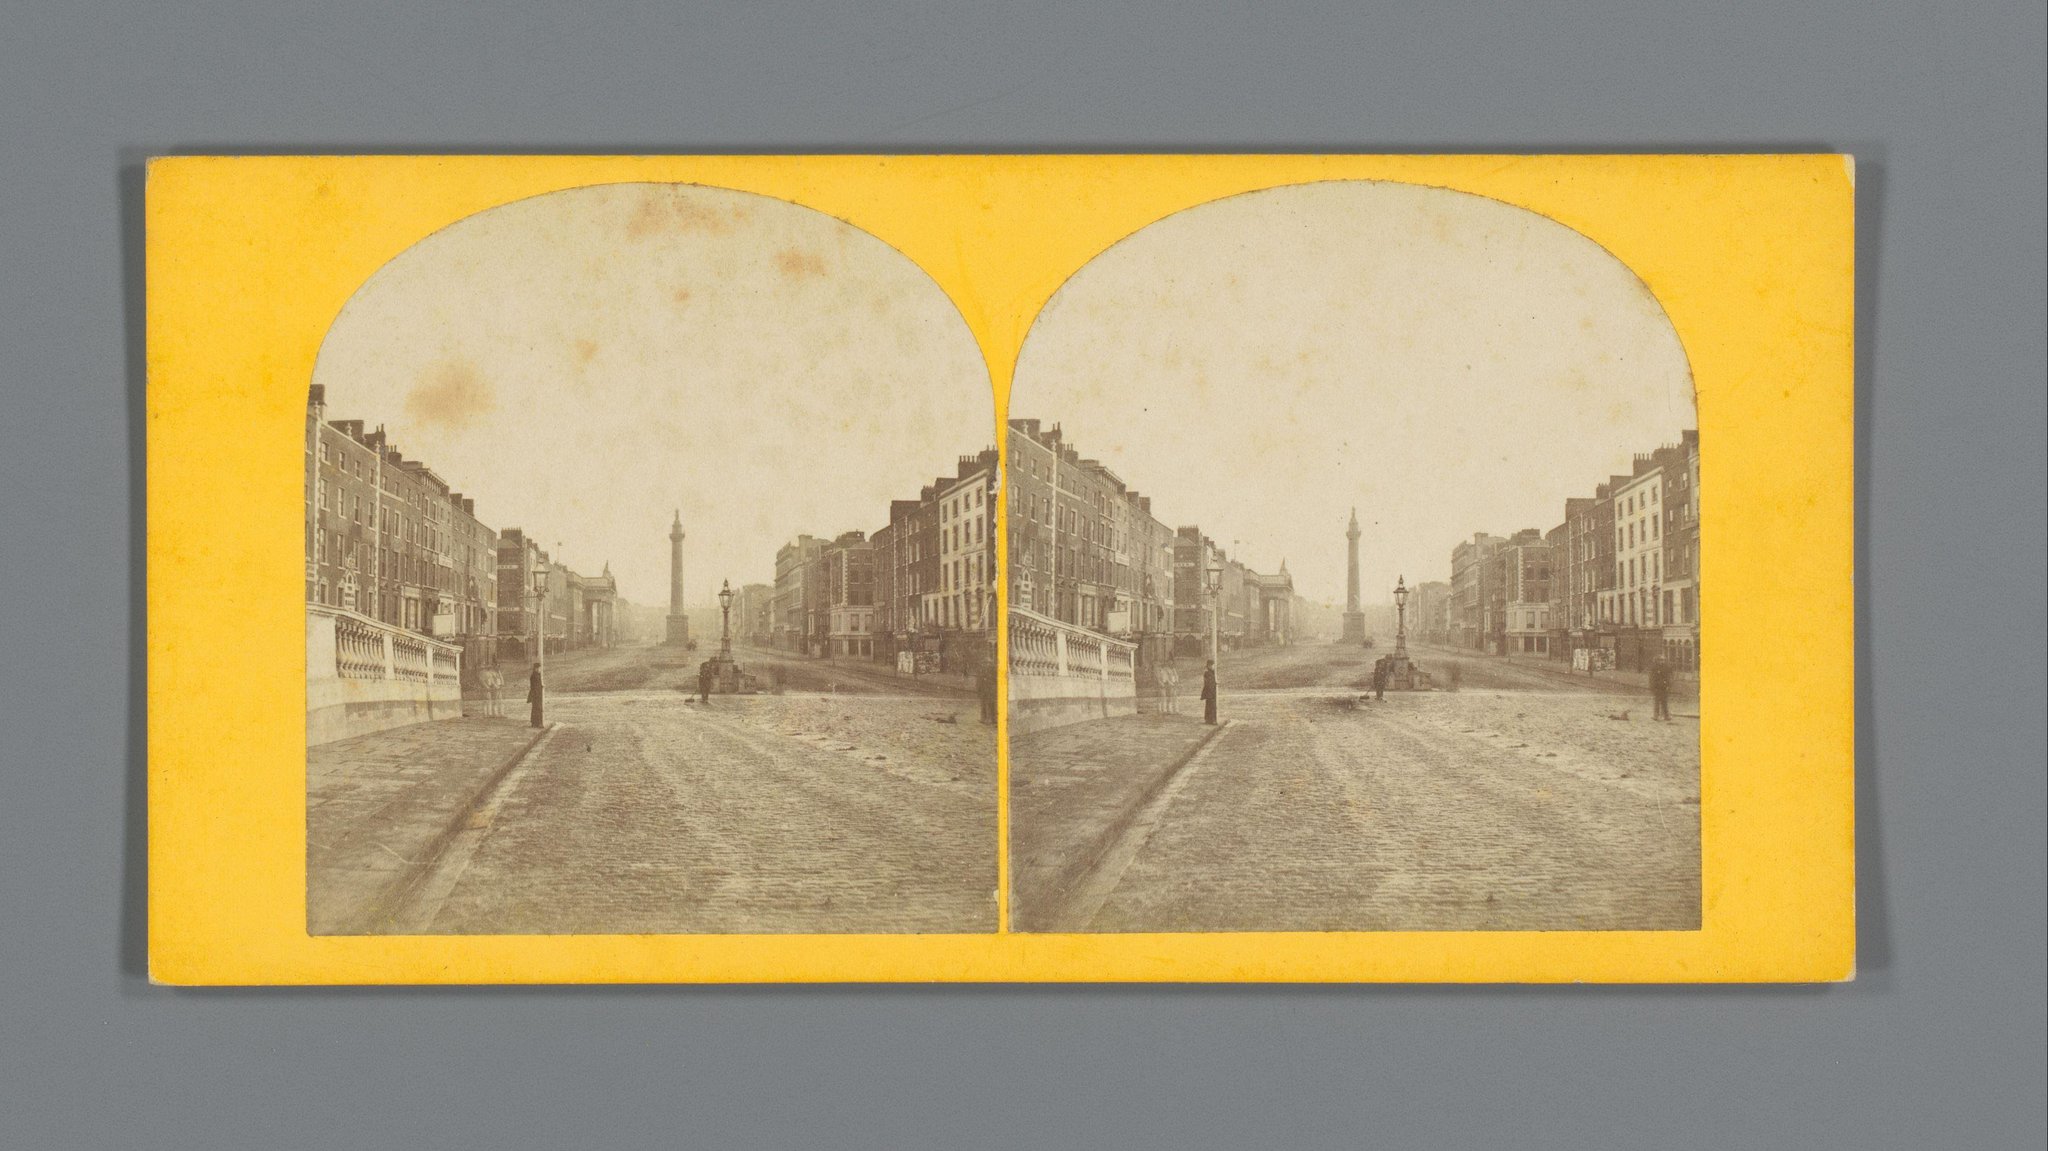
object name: stereograph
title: Gezicht op Sackville Street in Dublin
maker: Anonymous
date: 1861-1870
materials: cardboard, paper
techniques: albumen print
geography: dublin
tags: urban housing, obelisk, needle, street